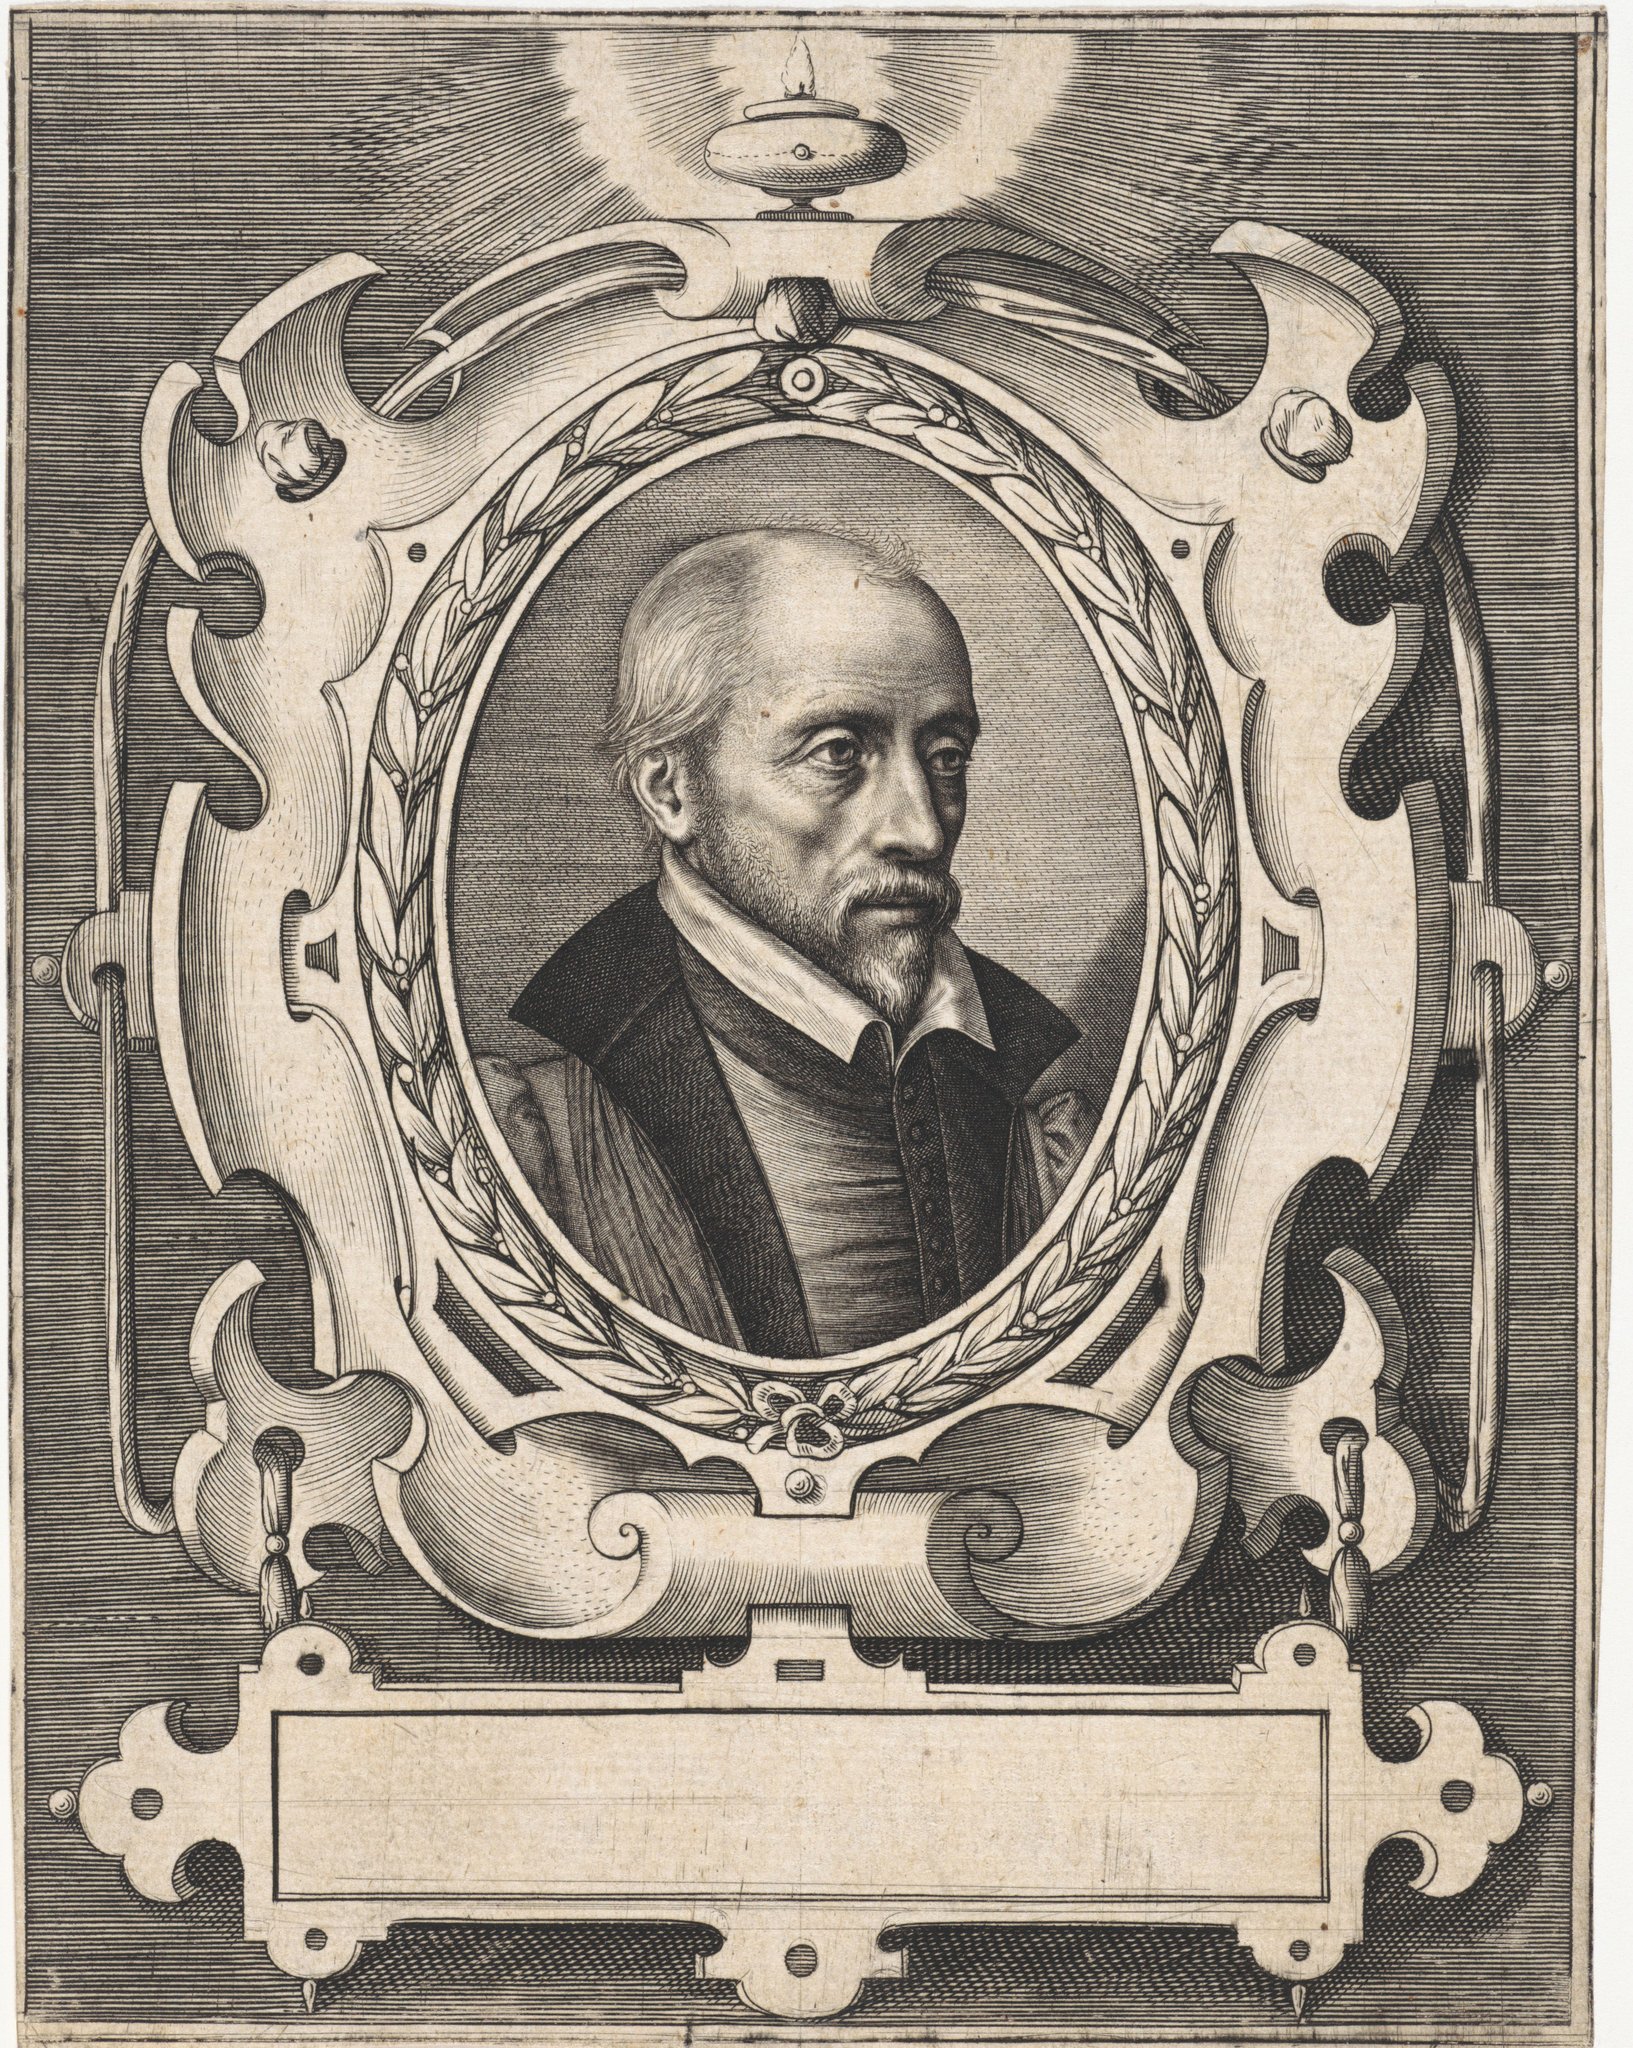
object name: print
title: Portret van de Franse politicus Louis d'Orléans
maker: hieronymus wierix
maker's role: draughtsman, print maker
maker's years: 1553-1619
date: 1602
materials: paper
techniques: engraving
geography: antwerp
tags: trees: laurel, oil-lamp, ornament ~ cartouche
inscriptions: collector's mark: Lugt 2228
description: Het portret is gevat in een cartouche met een lauwerkrans, bekroond met een brandende olielamp. Onderaan een leeg kader.